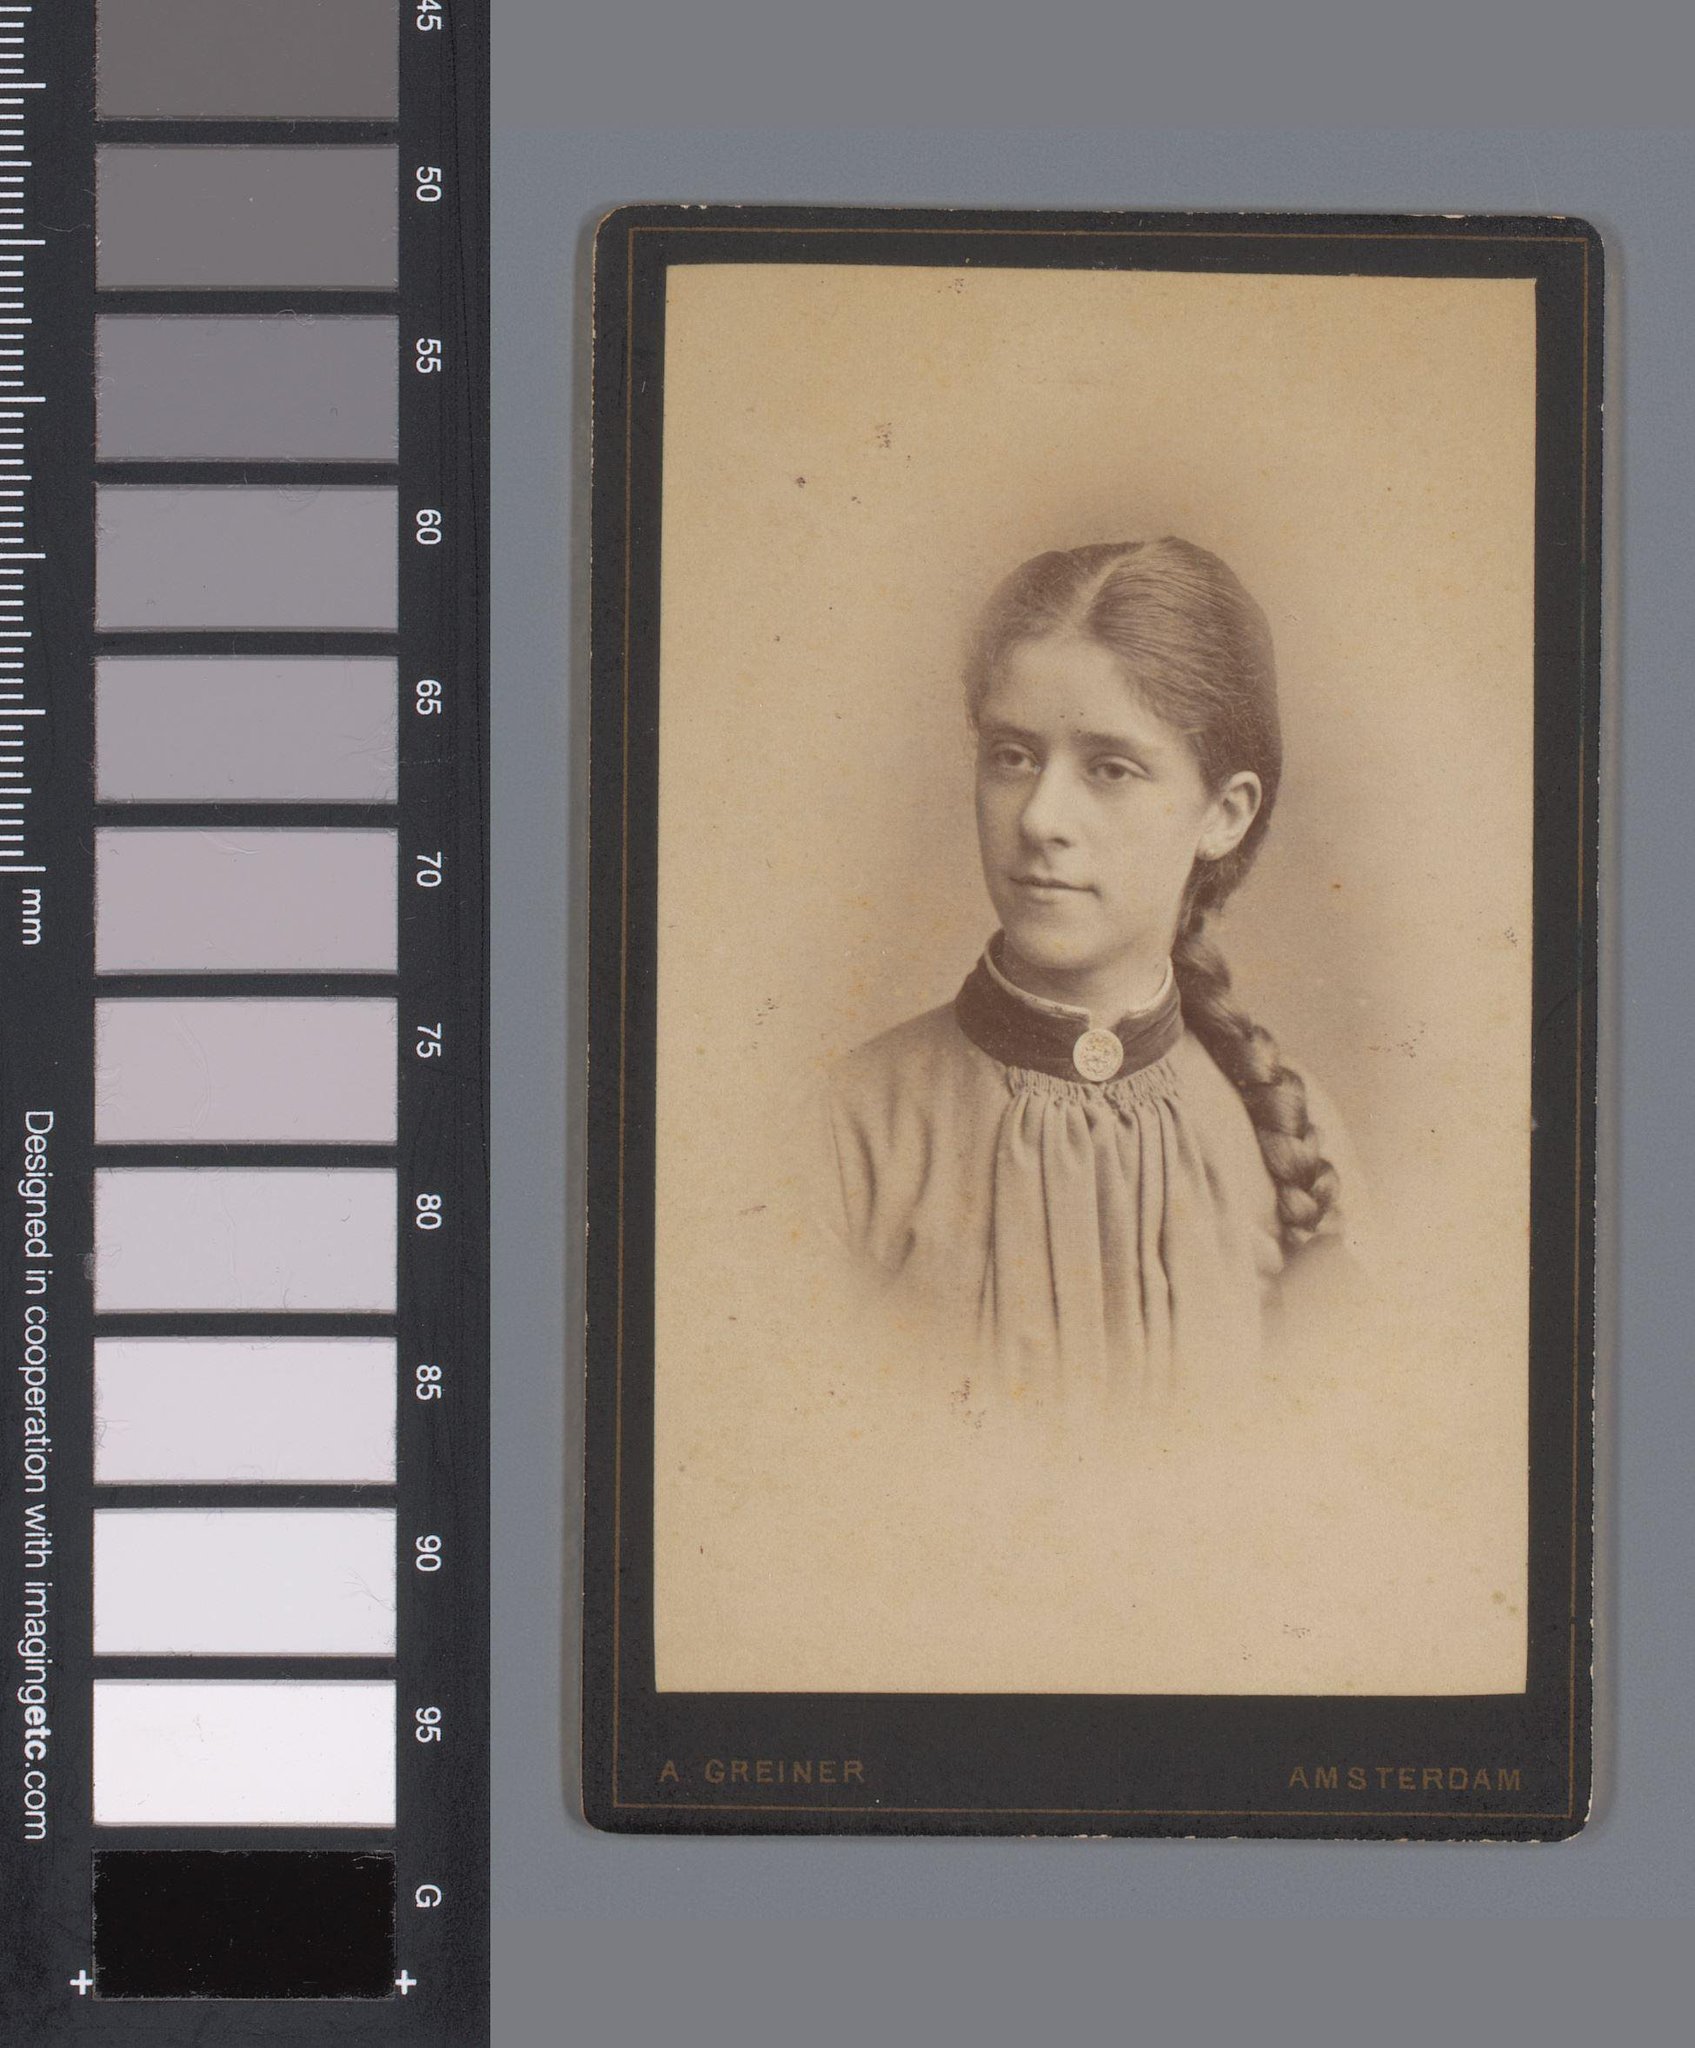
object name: carte de visite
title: Portret van Charlotte Hooykaas van der Linden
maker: albert greiner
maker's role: fotograaf, fotostudio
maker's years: 1833-1890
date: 1861-1874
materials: cardboard, photographic support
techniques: albumen print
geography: amsterdam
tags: historical persons, amsterdam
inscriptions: workshop stamp: ‘A. Greiner/ Photograaf/ Nieuwendijk L. 89, Amsterdam’, annotation: ‘Lot Hoogkaas v.d. Linden’